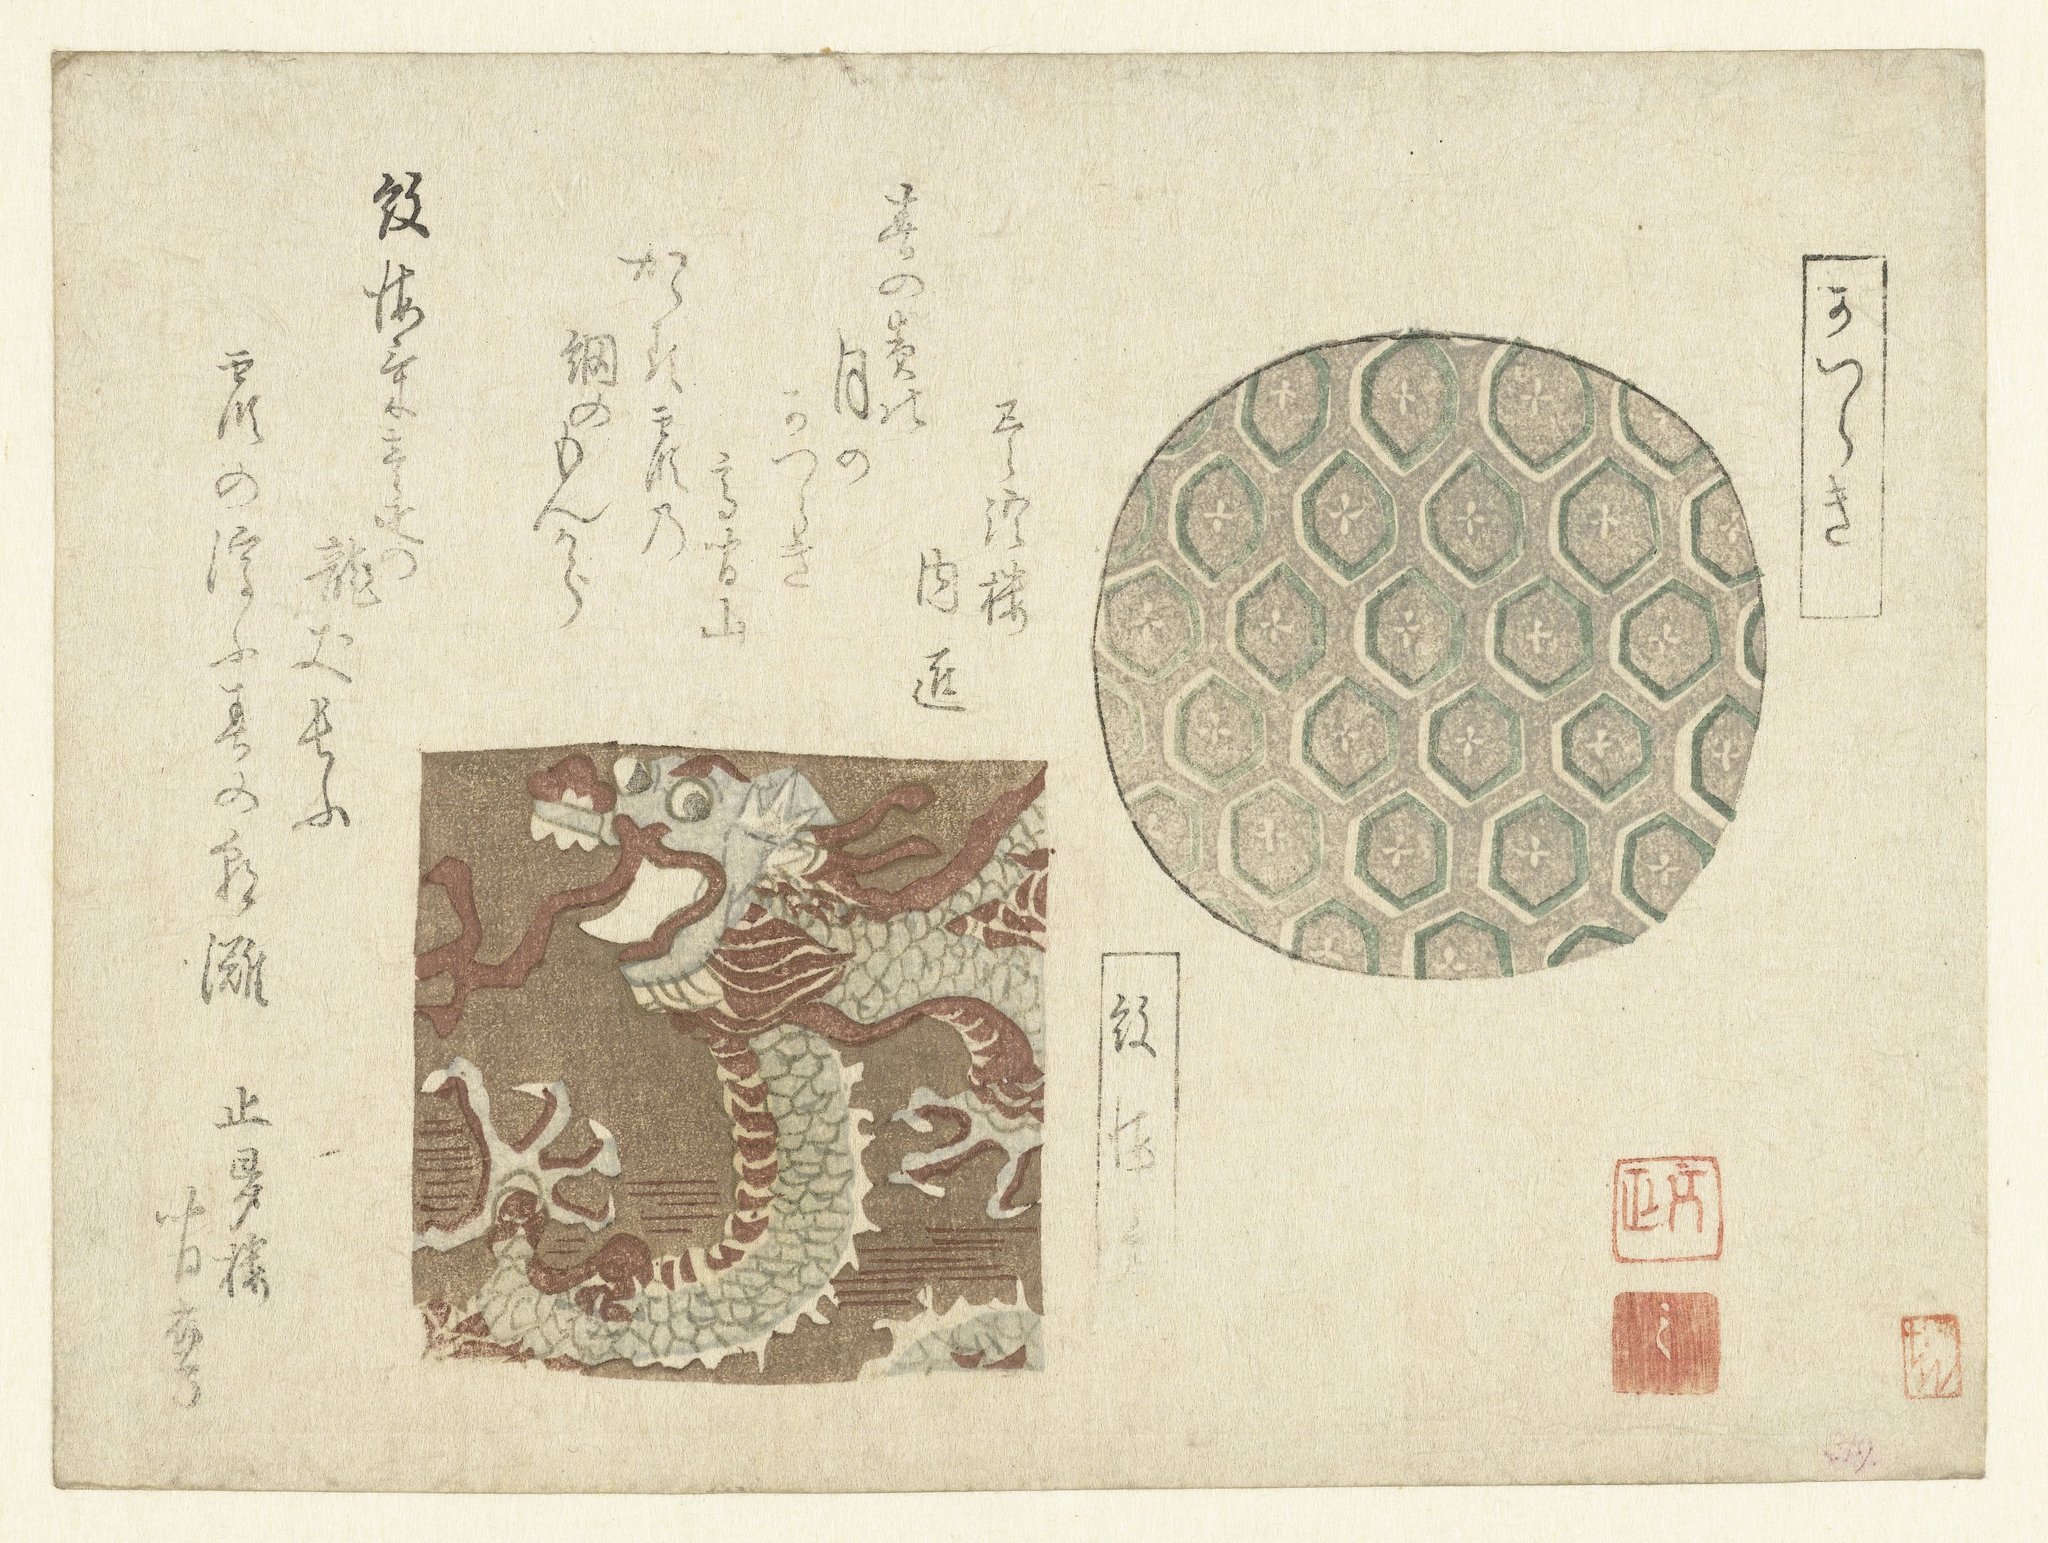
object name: print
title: Samples of Patterned Cloth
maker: masayuki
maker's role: print maker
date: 1796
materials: paper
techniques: woodcut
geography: japan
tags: dragon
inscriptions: collector's mark, recto, stamped: Lugt 1389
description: Een surimono is een luxe uitgevoerde prent waarop beeld met één of meerdere gedichten gecombineerd is. Bij het drukken van een surimono werd vaak gebruik gemaakt van dikker papier, blinddruk en metaal pigmenten, zoals koper- en zilverpoeder. De prenten werden vaak in opdracht van dichters gemaakt en als exclusief geschenk aan vrienden en relaties gegeven.